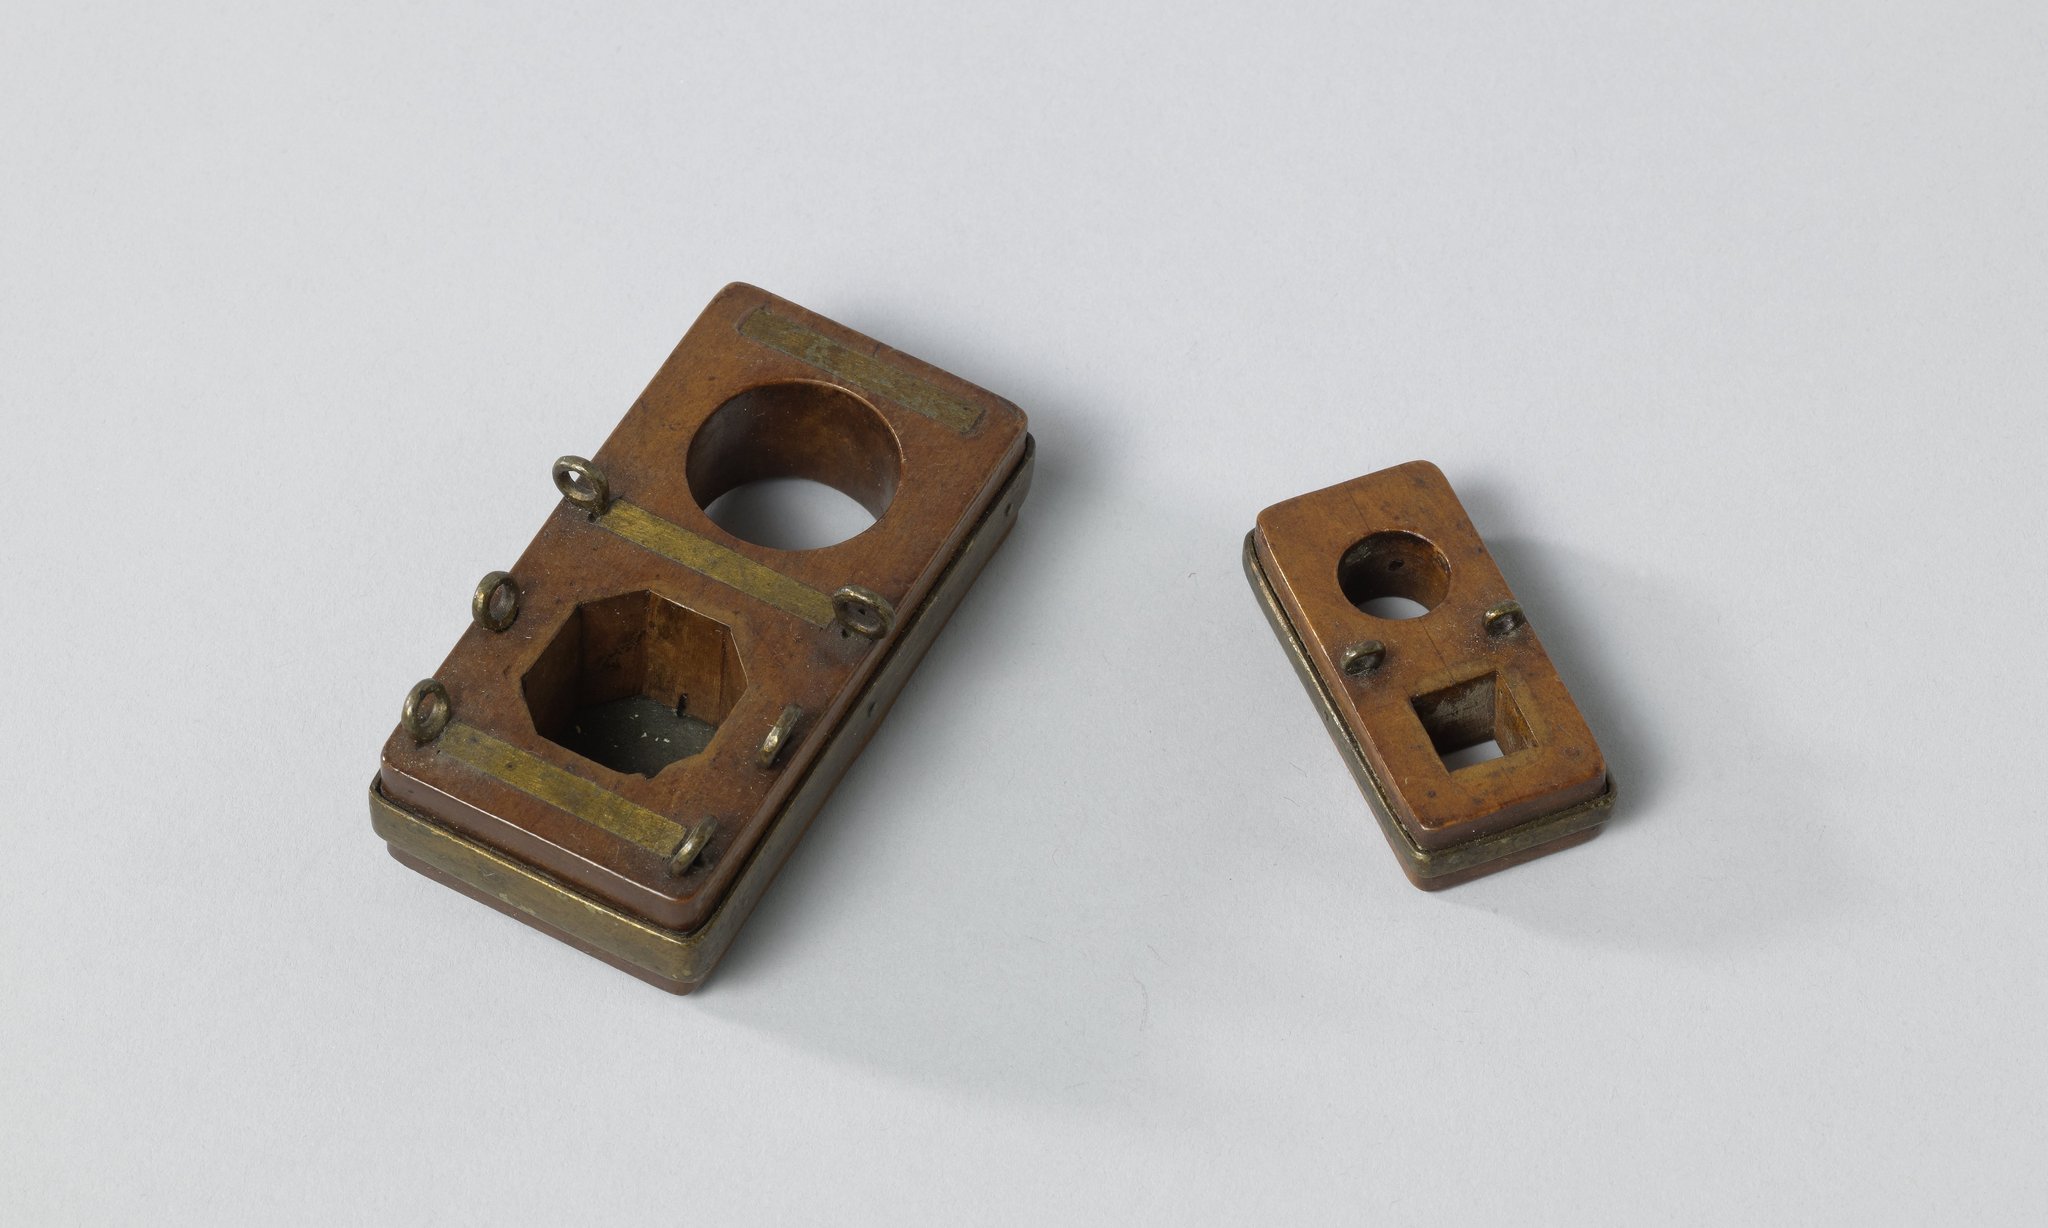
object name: demonstration model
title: Two Models of Mast Caps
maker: Anonymous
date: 1850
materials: brass, wood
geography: netherlands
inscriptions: inscription, on model A: ‘R’, inscription, on model B: ‘V’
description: Dit model stelt de ezelshoofden van de grote mast van de Piet Hein voor, in 1833 als linieschip op stapel gezet, uiteengenomen en in 1853-1856 als eerste Nederlands schroefstoomfregat afgebouwd door A.E. Tromp in Amsterdam, lang 59.62 m, herdoopt de Admiraal van Wassenaer. Samen met een aantal modellen van rondhouten kan de gehele grote mast gevormd worden.